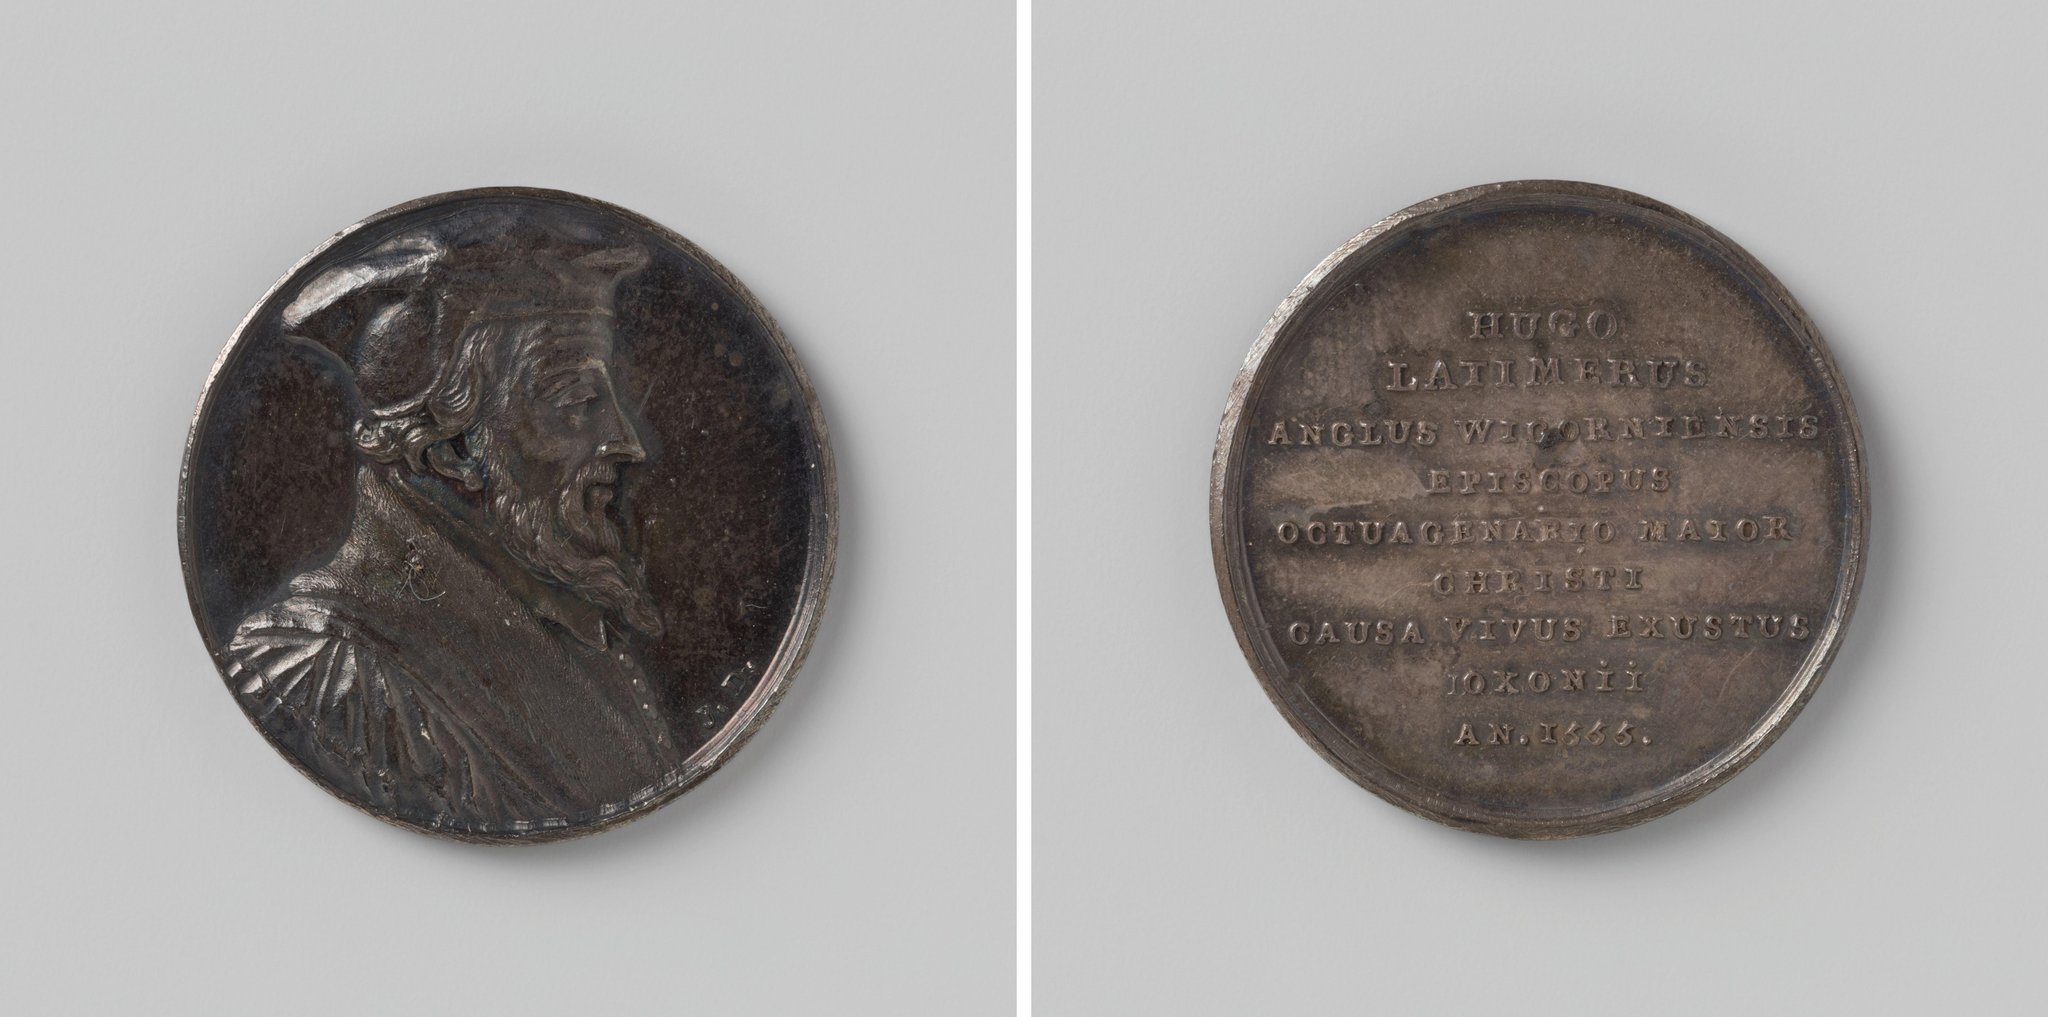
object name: history medal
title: Verbranding van Hugh Latimer, bisschop van Worcester, te Oxford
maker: jean dassier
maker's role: medailleur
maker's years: 1676-1763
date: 1725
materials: silver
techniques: striking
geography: geneva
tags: bisschop, hugh latimer, oxford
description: Zilveren penning. Voorzijde: borststuk man. Keerzijde: opschrift.